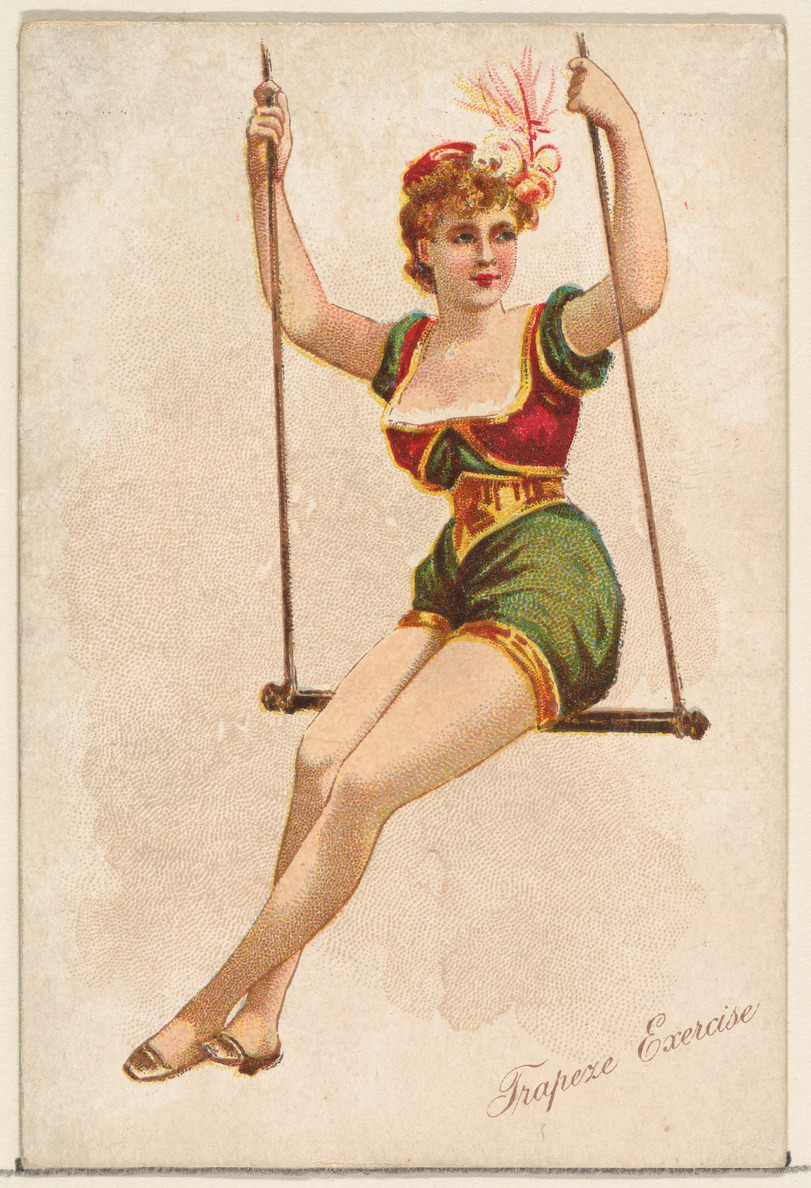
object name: print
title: Trapeze Exercise, from the Pretty Athletes series (N196) issued by Wm. S. Kimball & Co.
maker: william s. kimball & company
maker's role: publisher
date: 1889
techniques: color lithograph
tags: women,athletes